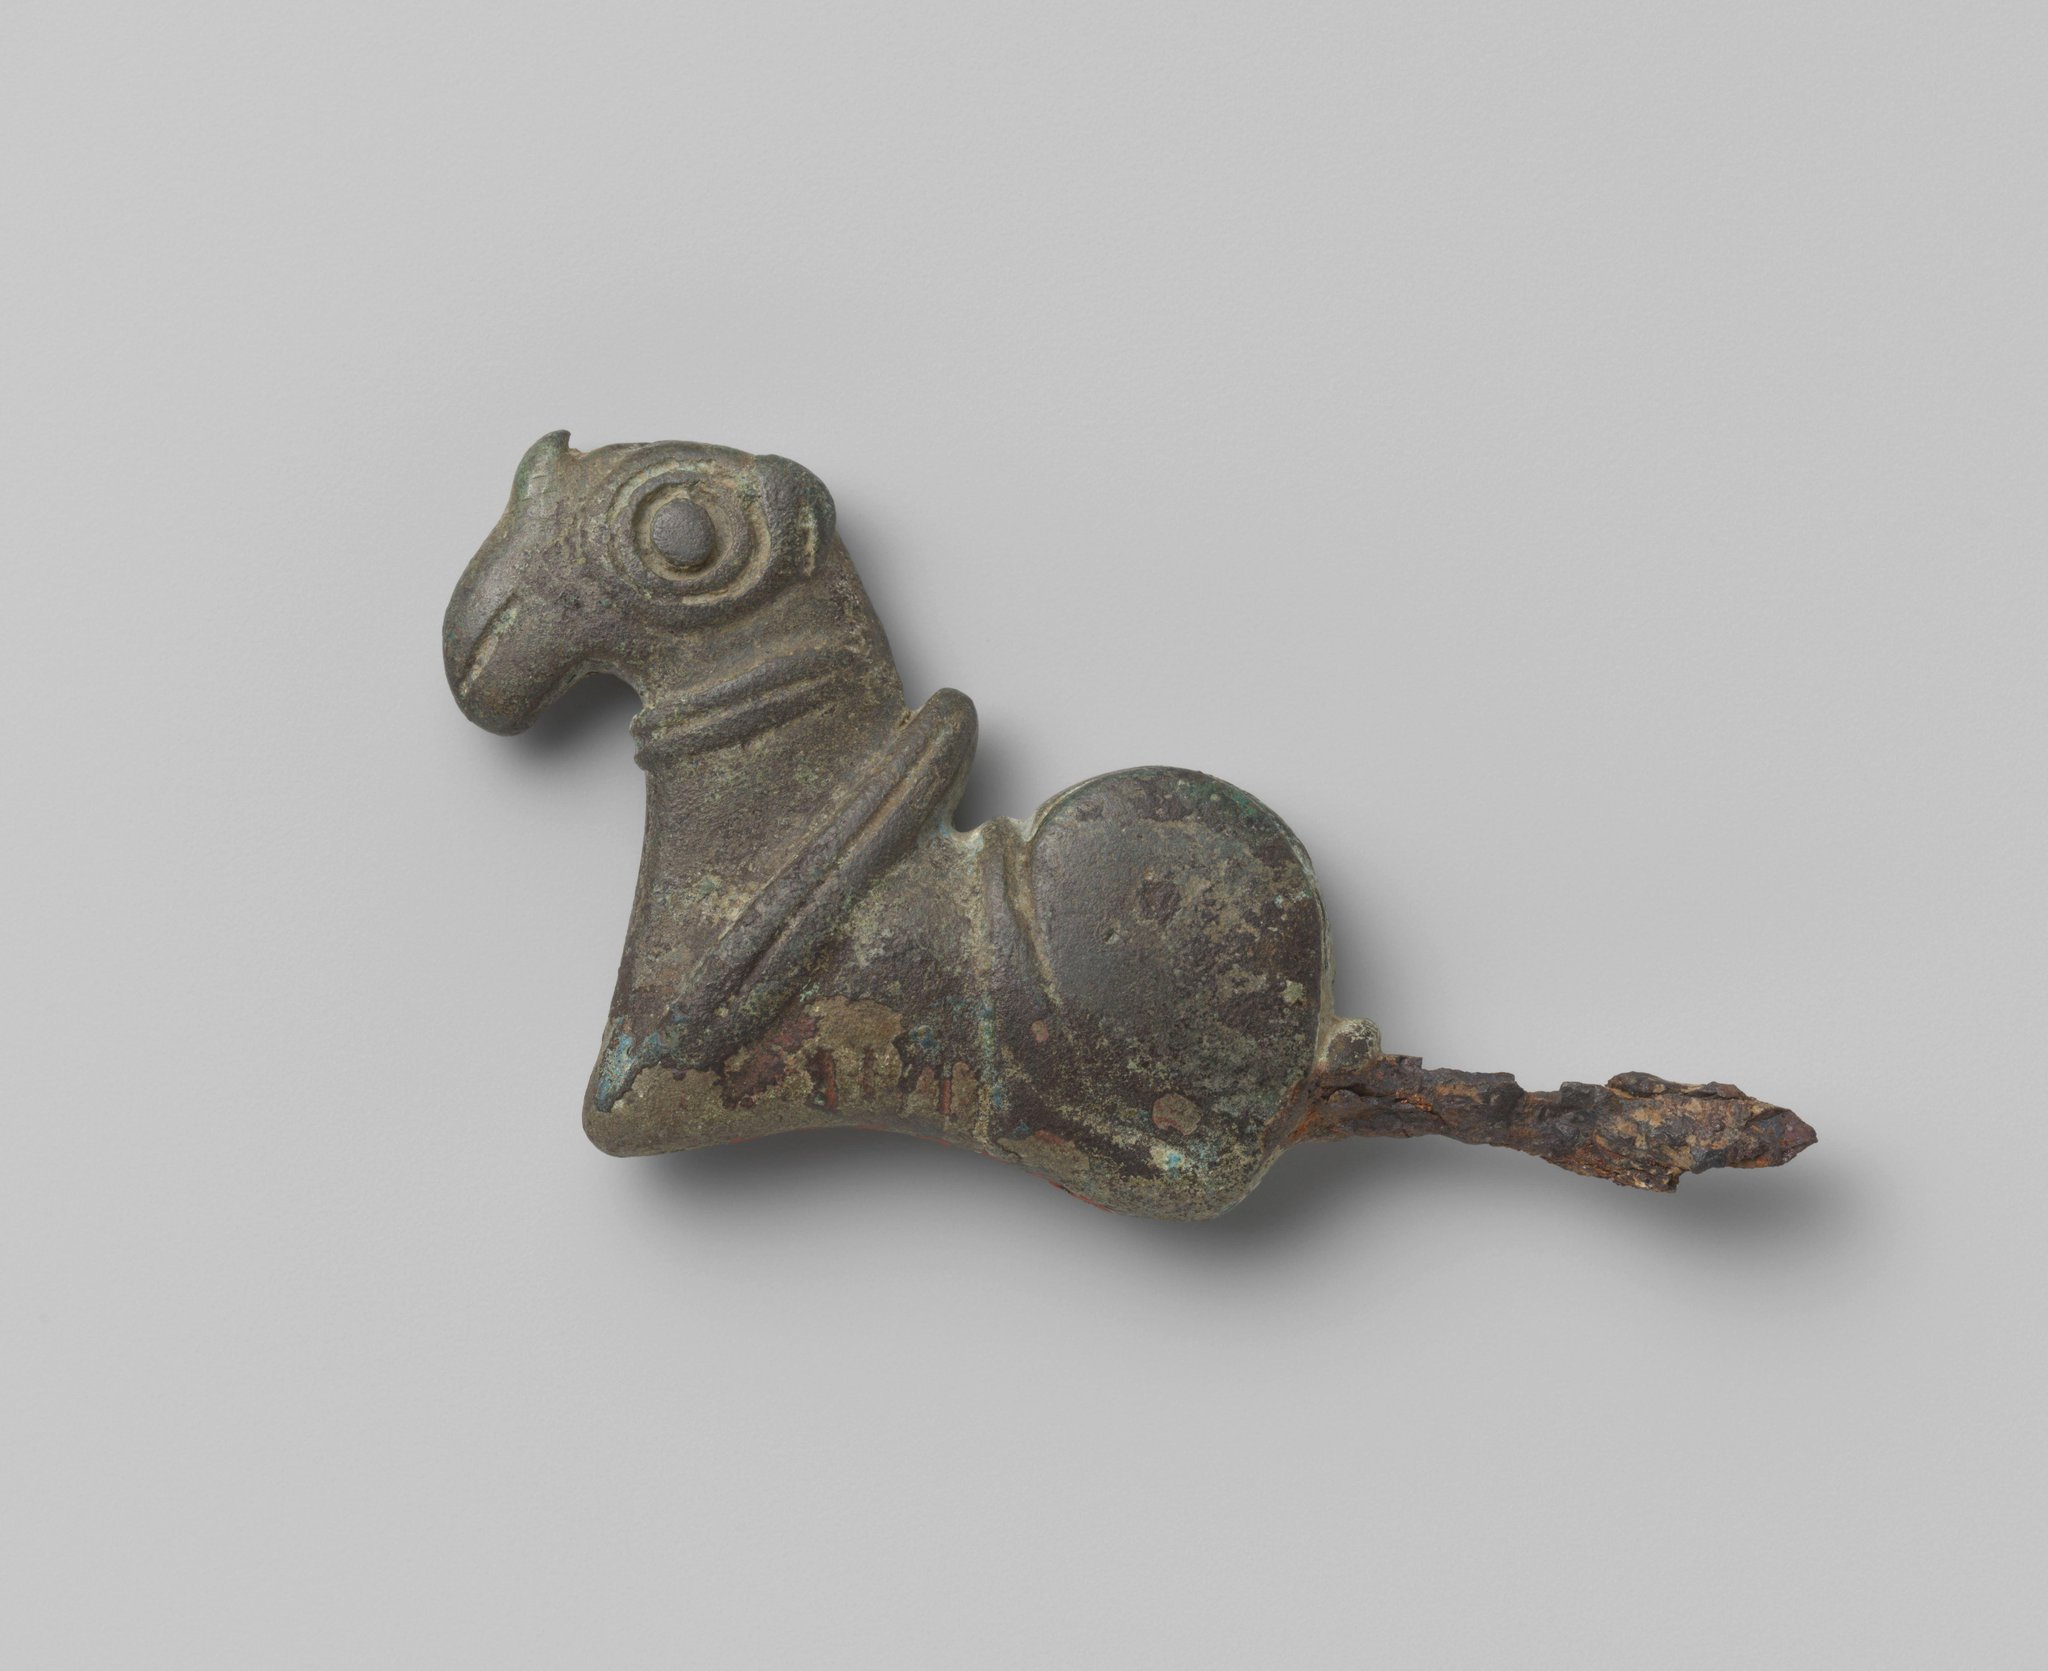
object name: figure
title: Fragment van een voorwerp in de vorm van een gestileerde ram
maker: Anonymous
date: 1400-1950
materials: bronze, iron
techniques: casting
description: Fragment van een bronzen voorwerp in de vorm van een gestileerde ram, waaraan een ijzeren steel is bevestigd